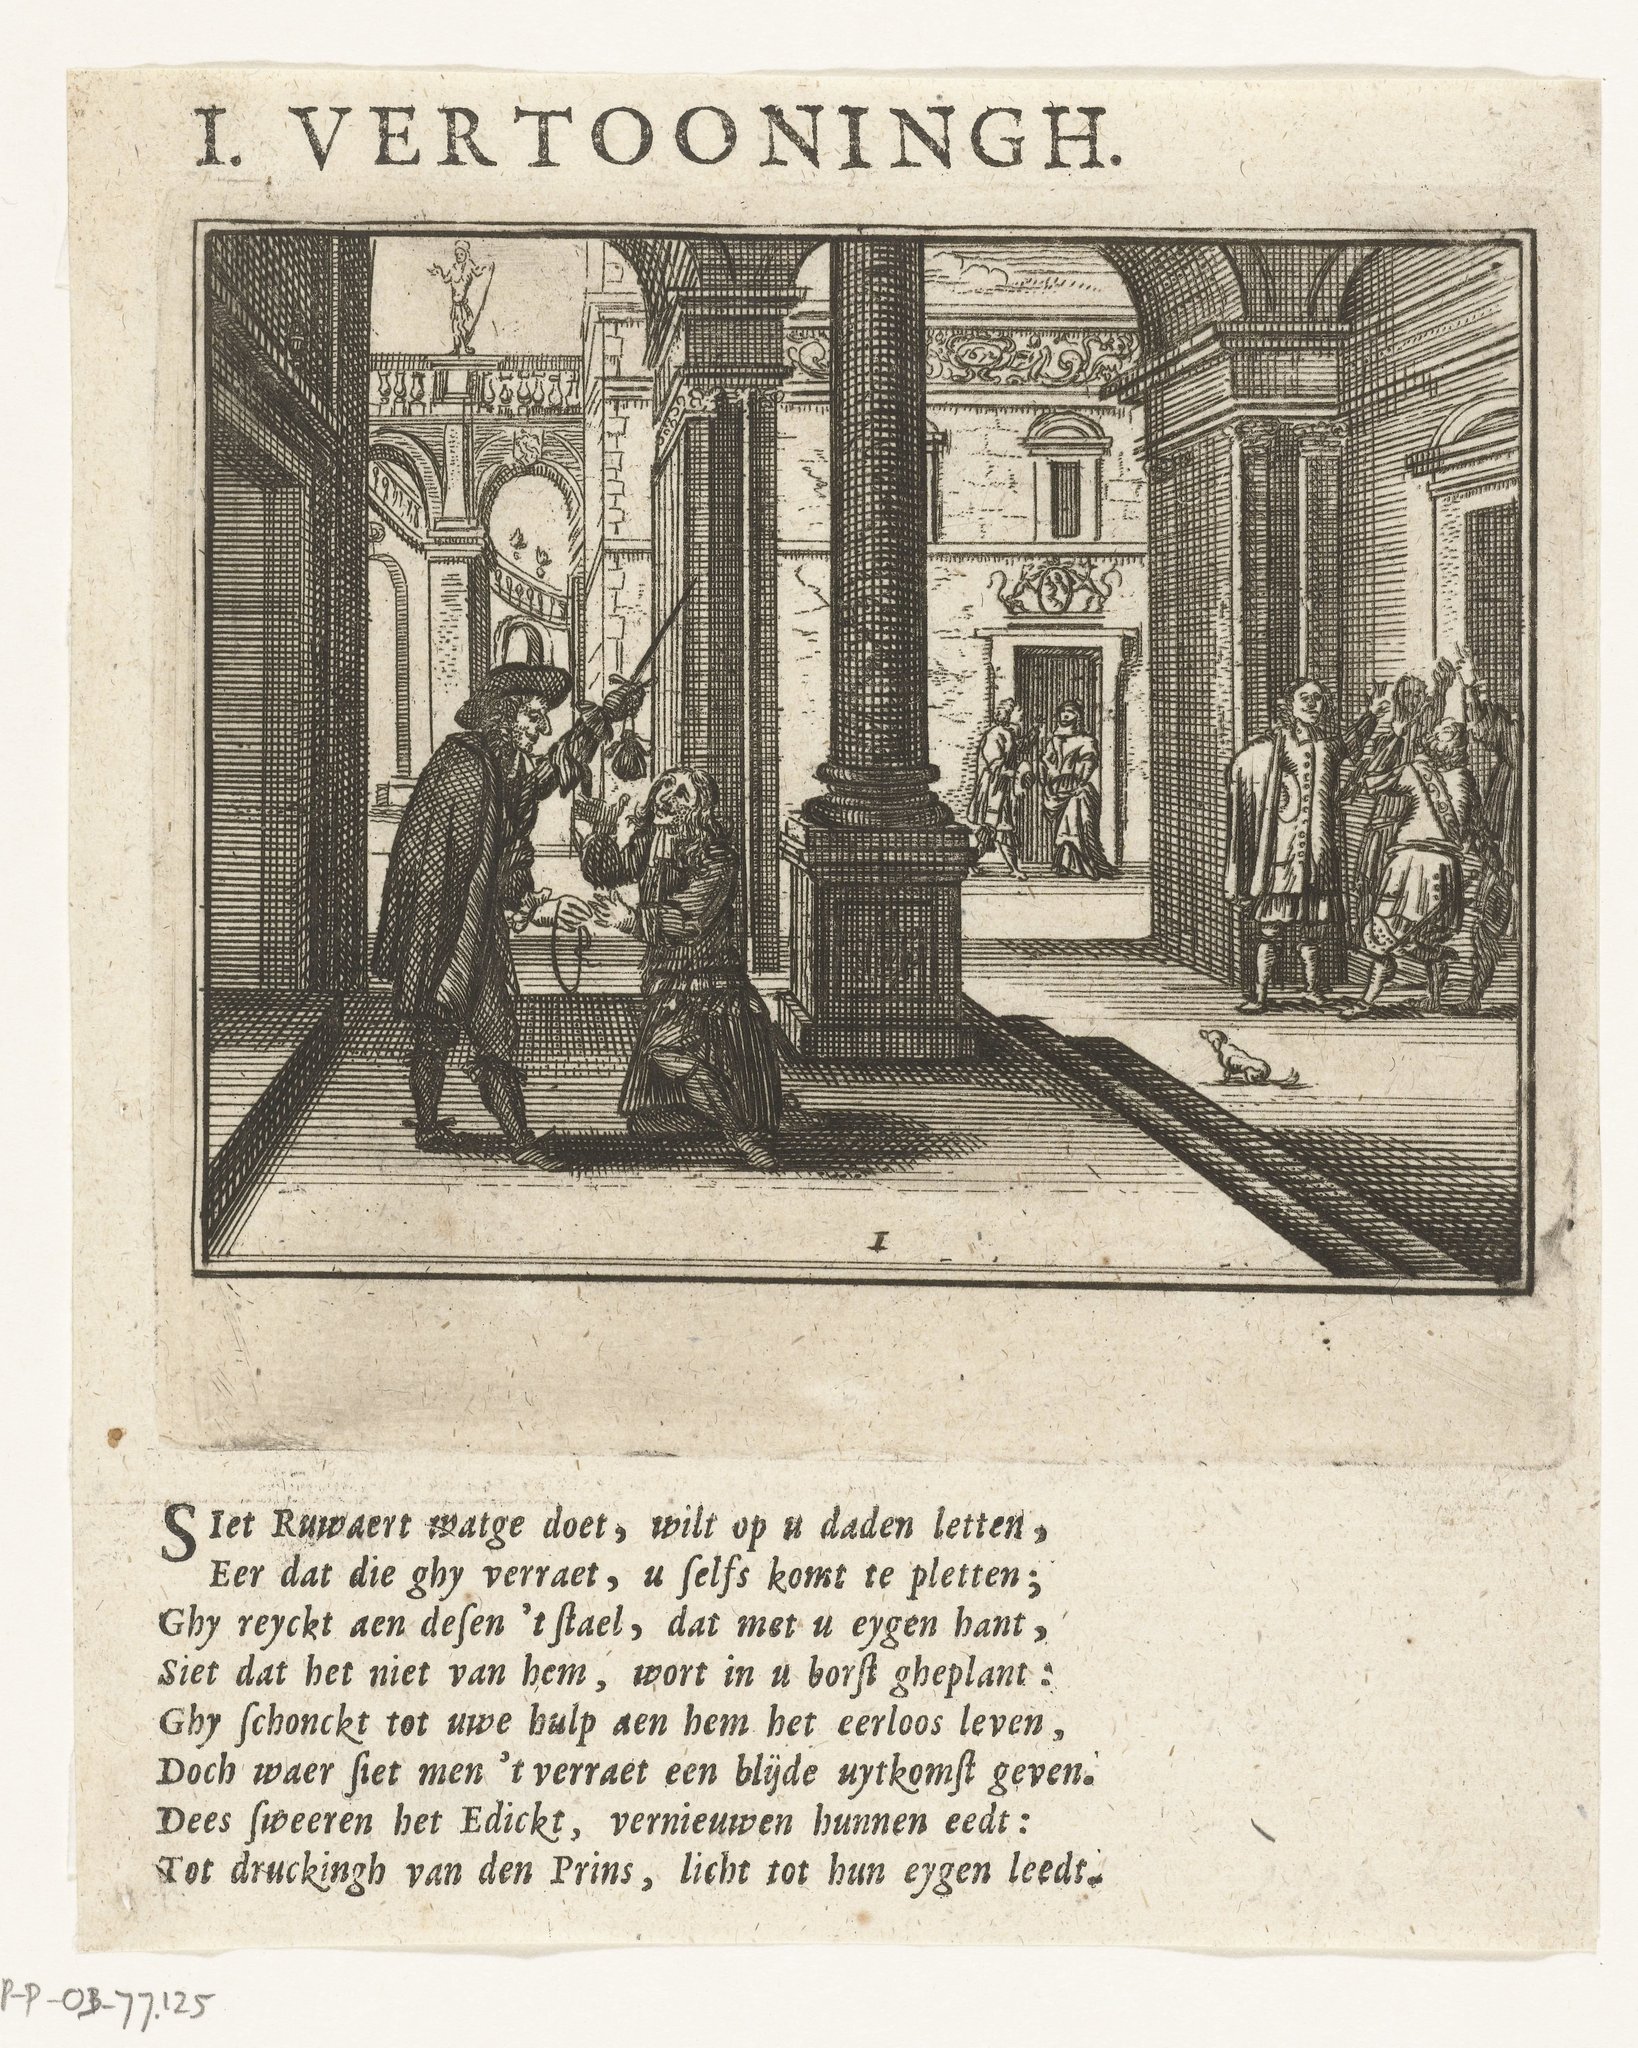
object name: book illustration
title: Cornelis de Witt geeft verschoning aan een verkrachter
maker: Anonymous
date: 1672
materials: paper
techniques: etching, letterpress printing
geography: southern netherlands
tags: cornelis de witt, politician, johan de witt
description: Cornelis de Witt verschoning geeft aan een verkrachter. Scène uit het leven van Johan en Cornelis de Witt; onderdeel van een groep illustraties, genummerd: I. Vertooningh en vergezeld van een vers van 8 regels. Bedrukt op achterzijde met tekst in het Nederlands.